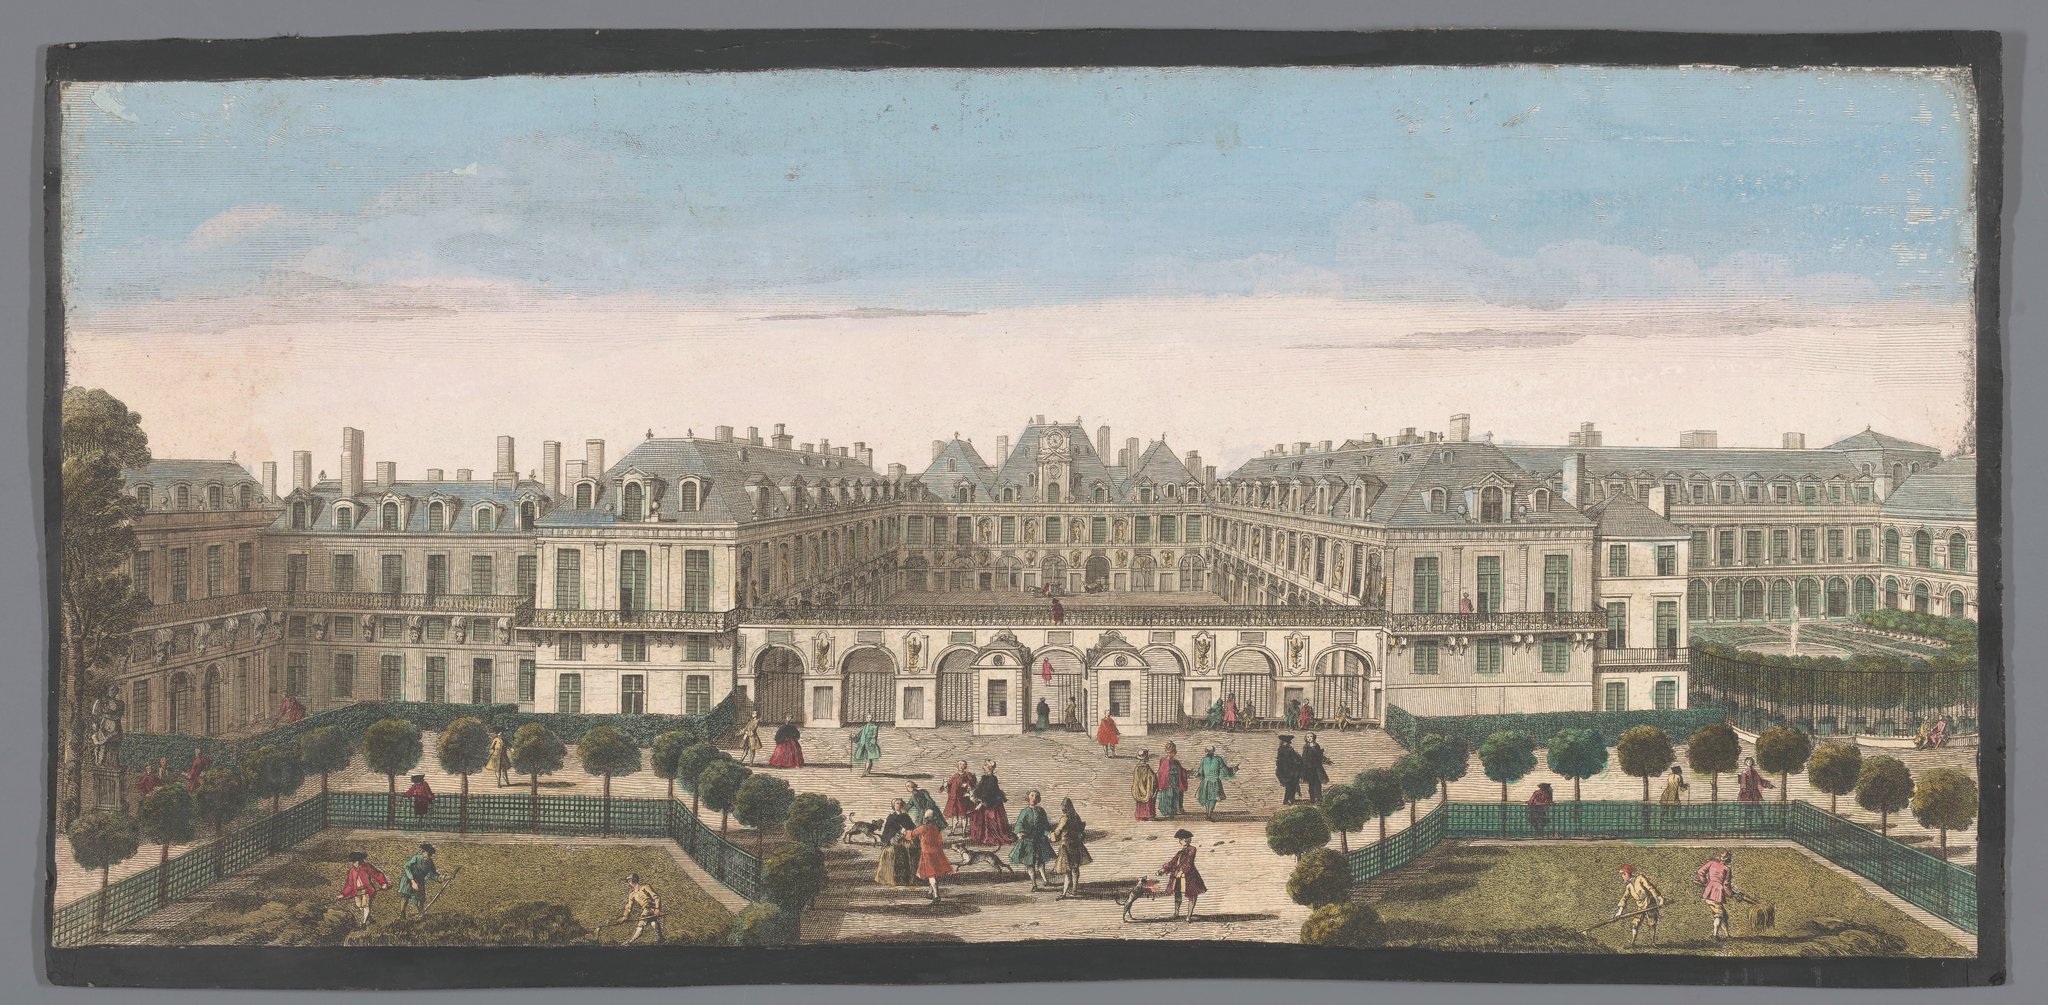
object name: opticaprent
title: Vûë du Palais Royal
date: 1700-1799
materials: cardboard, paper, watercolor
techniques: brush, etching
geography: paris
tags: palace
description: In de ondermarge een regel Franse tekst.